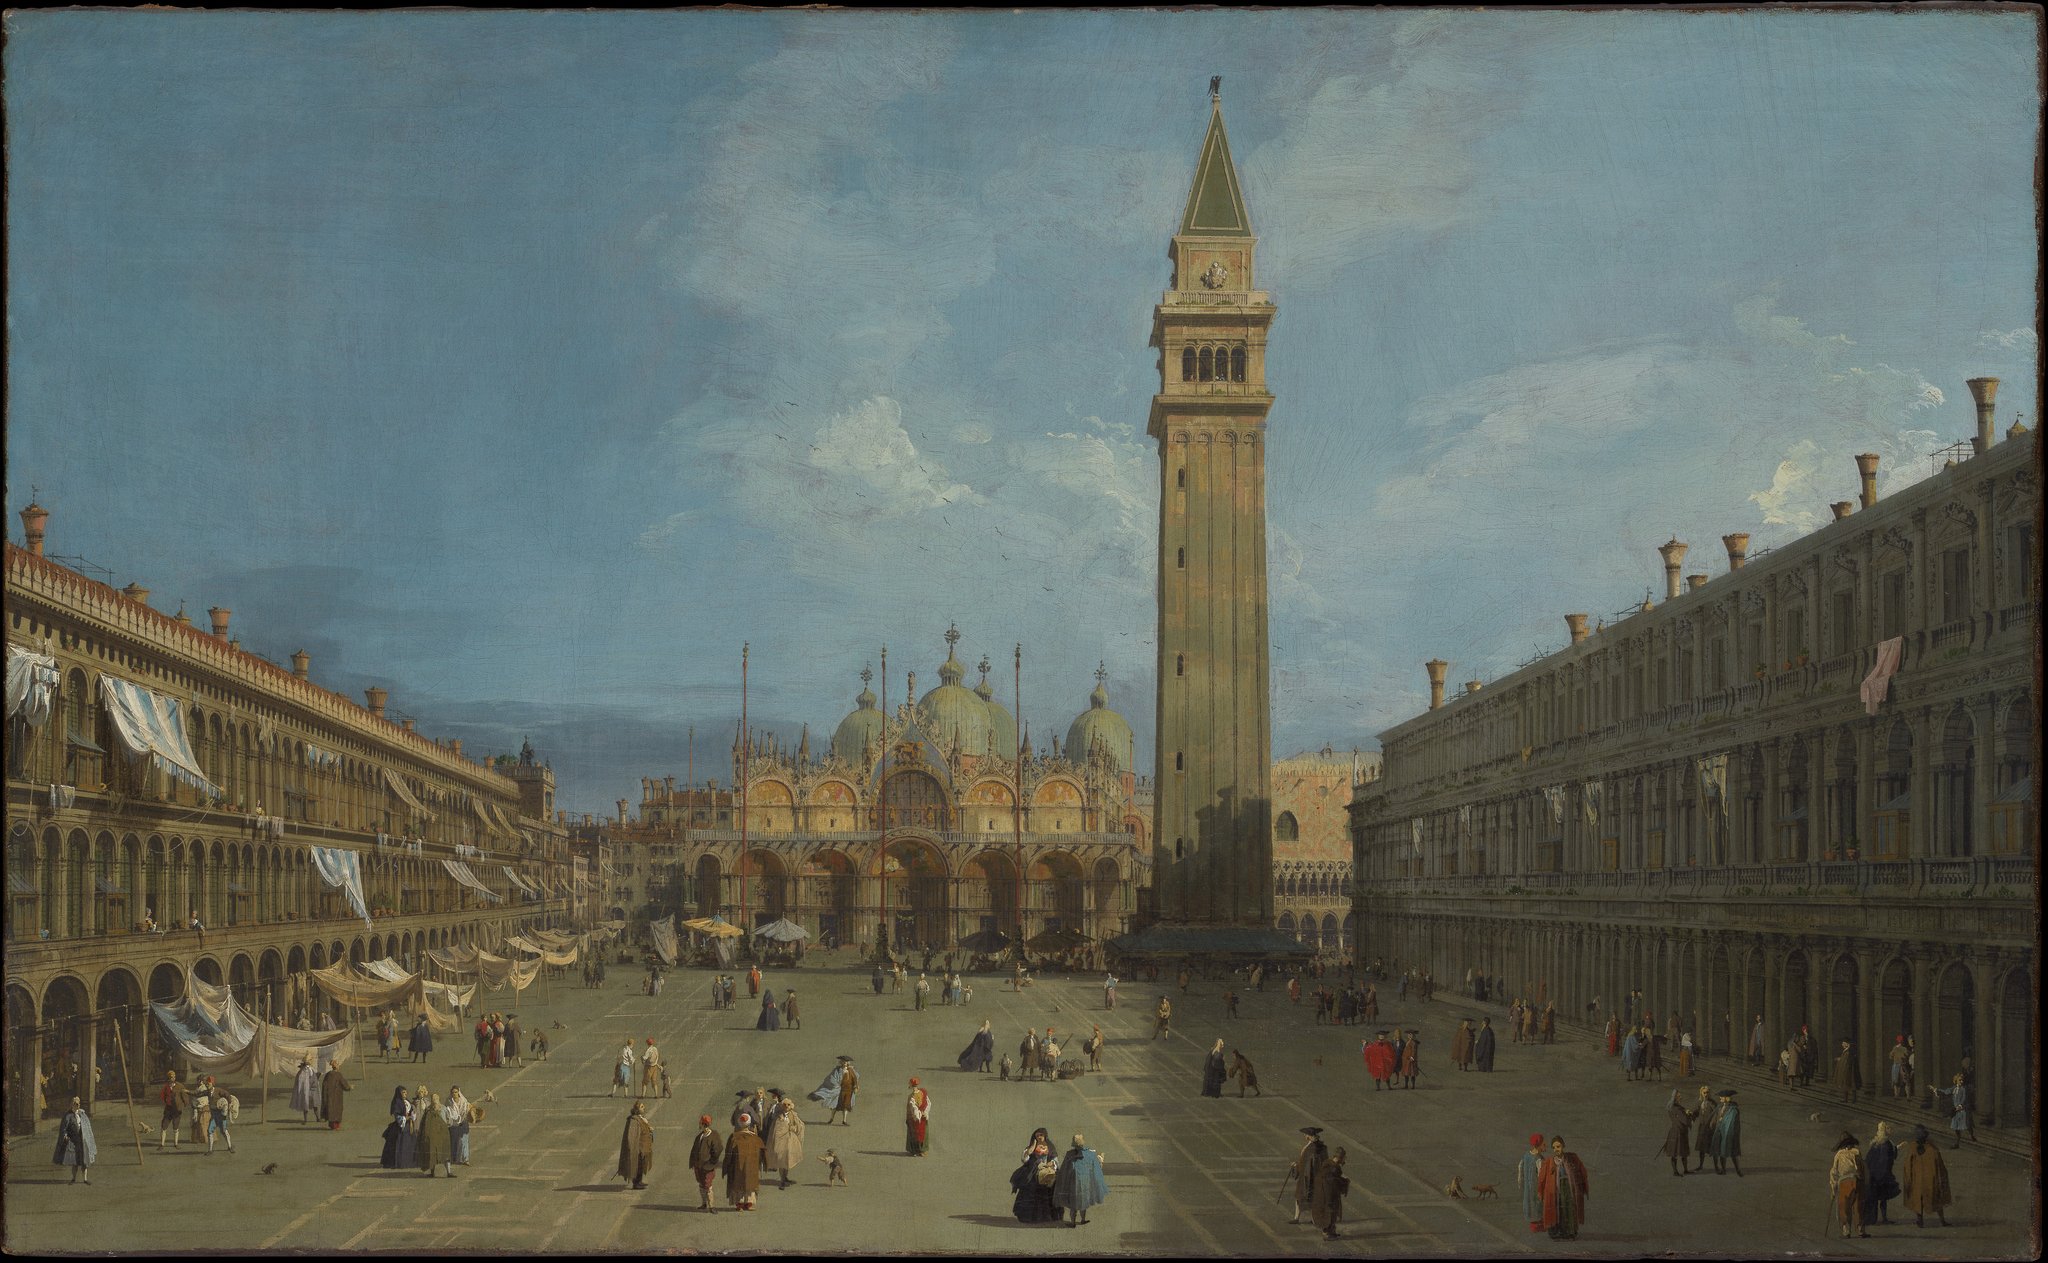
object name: painting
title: Piazza San Marco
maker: canaletto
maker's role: artist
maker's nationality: italian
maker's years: 1697-1768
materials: canvas, oil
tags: towers,cities,venice